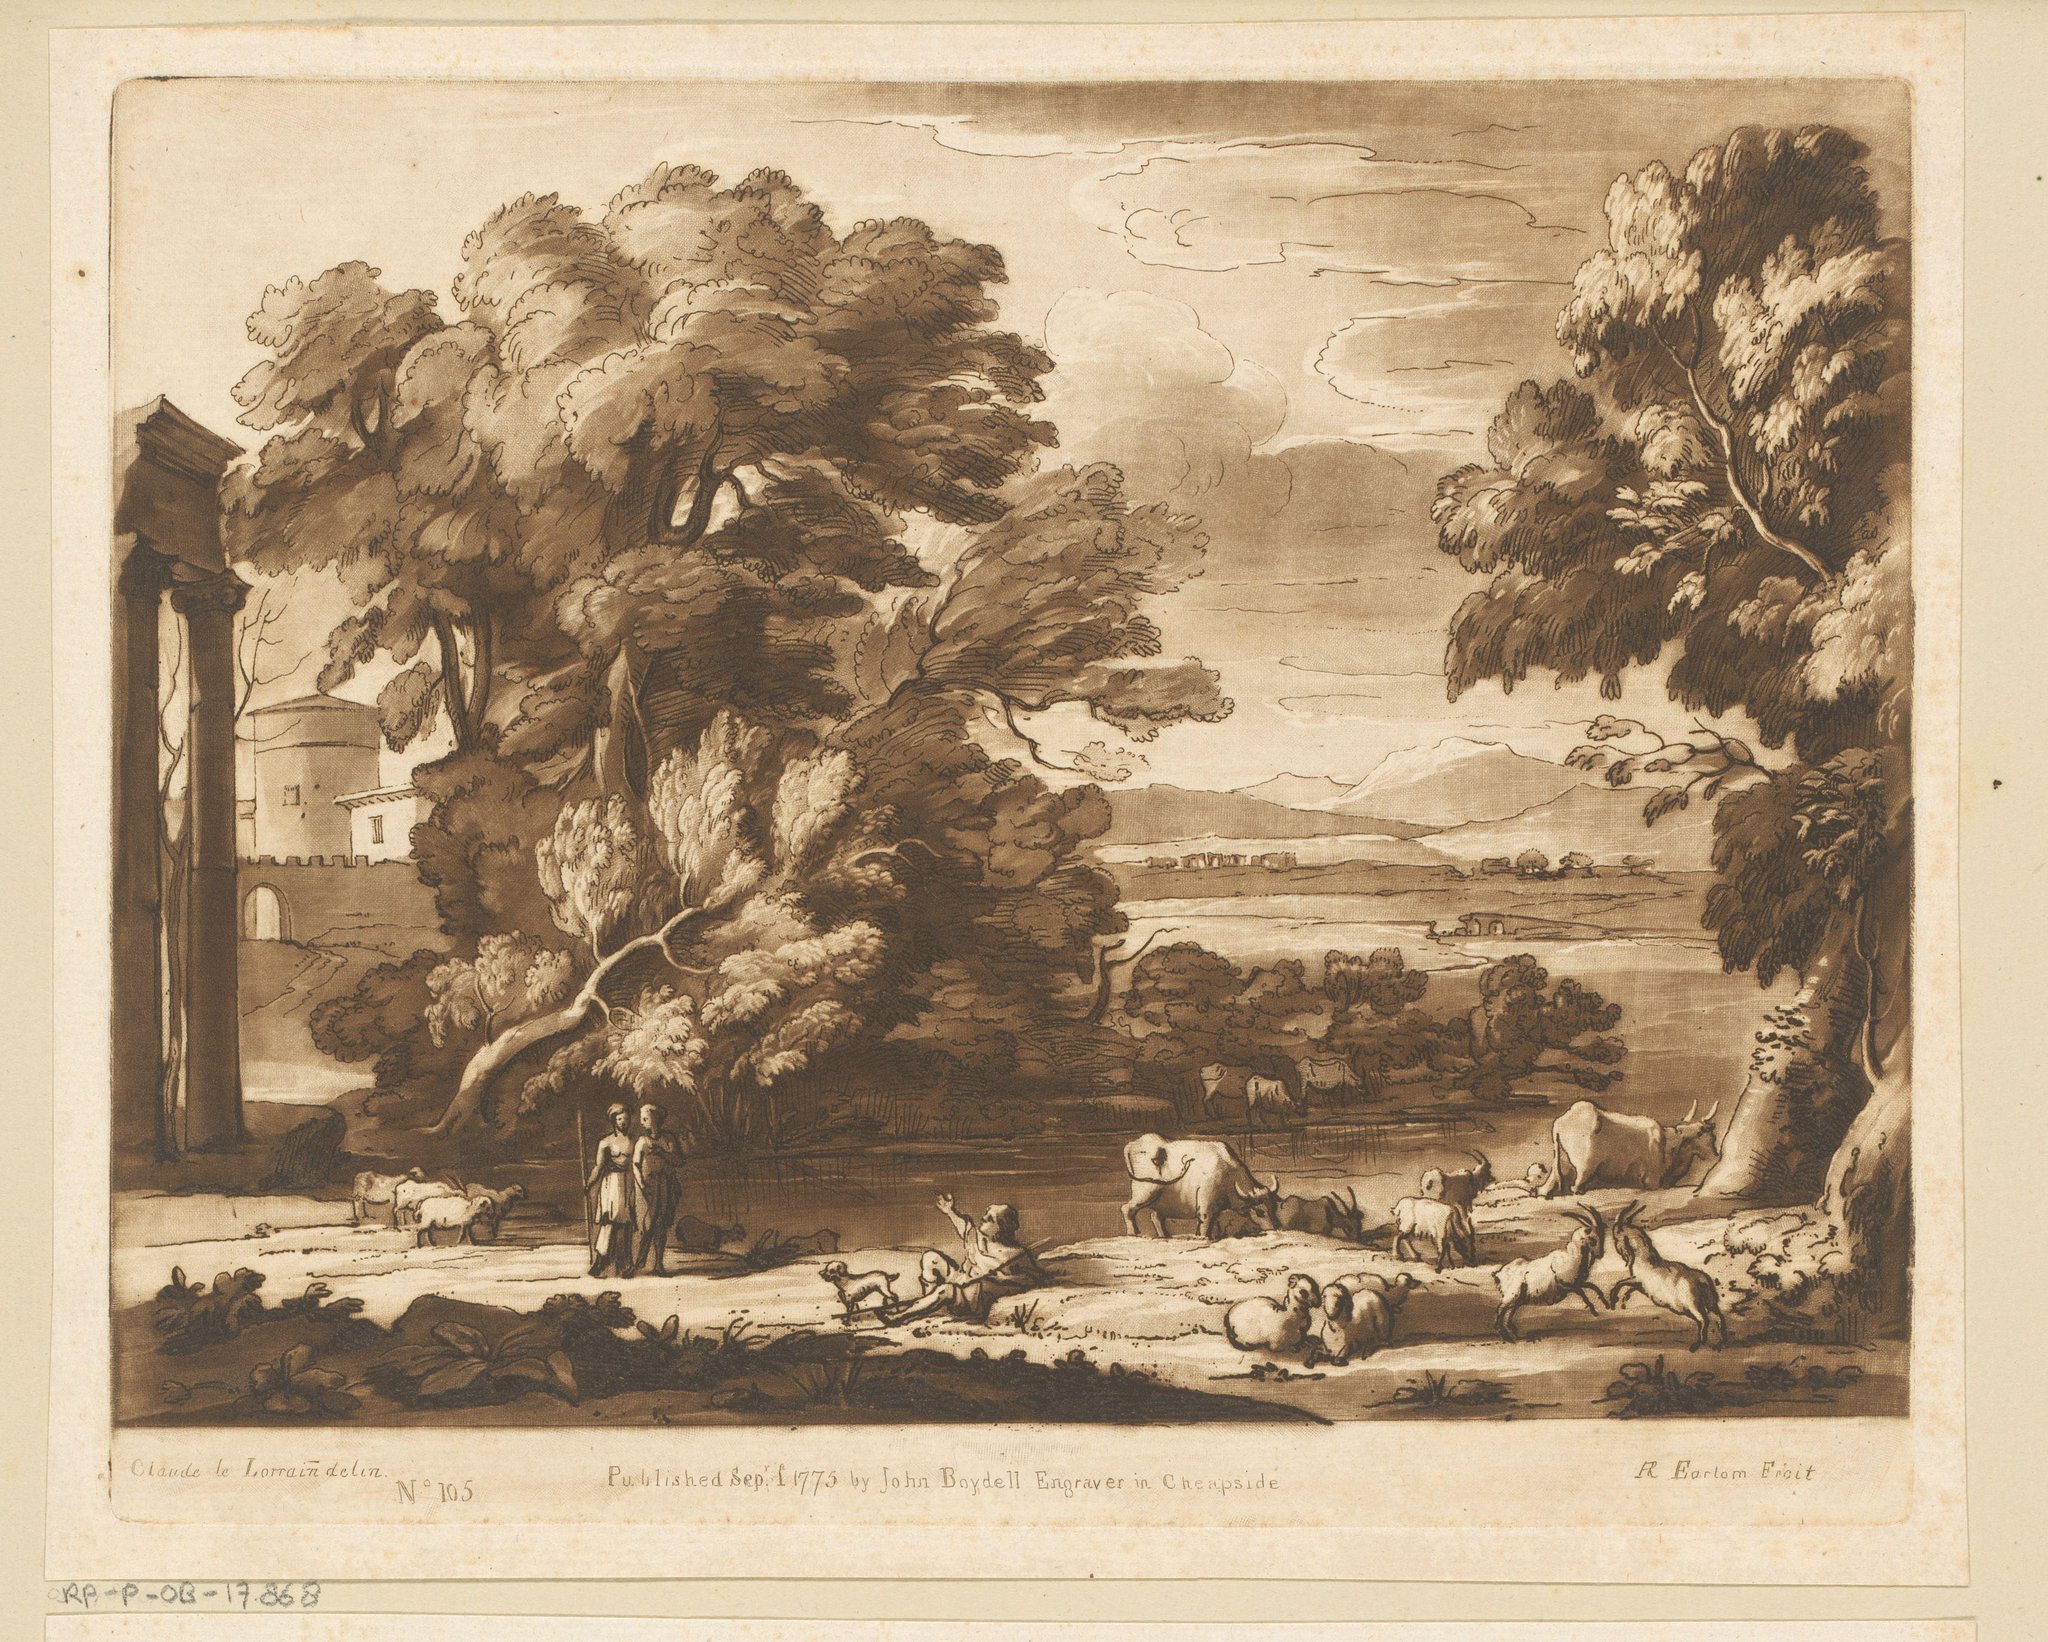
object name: print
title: Liber Veritatis. Or a Collection of Two Hundred Prints, after the original designs of Claude le Lorrain (...)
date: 1775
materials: paper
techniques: etching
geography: london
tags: herding, herdsman, herdswoman, shepherd, shepherdess, cowherd, etc., cattle, landscape with ruins - ii - ideal landscapes, pastorals, arcadian scenes, lake - hh - ideal landscapes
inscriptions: date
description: Vanaf 1774 publiceerde John Boydell tweehonderd prenten naar het tekeningenboek Liber Veritatis van Claude Lorrain, in het bezit van de hertogen van Cavendish. Deze prenten werden vanaf 1777 in twee volumes gebundeld uitgegeven.